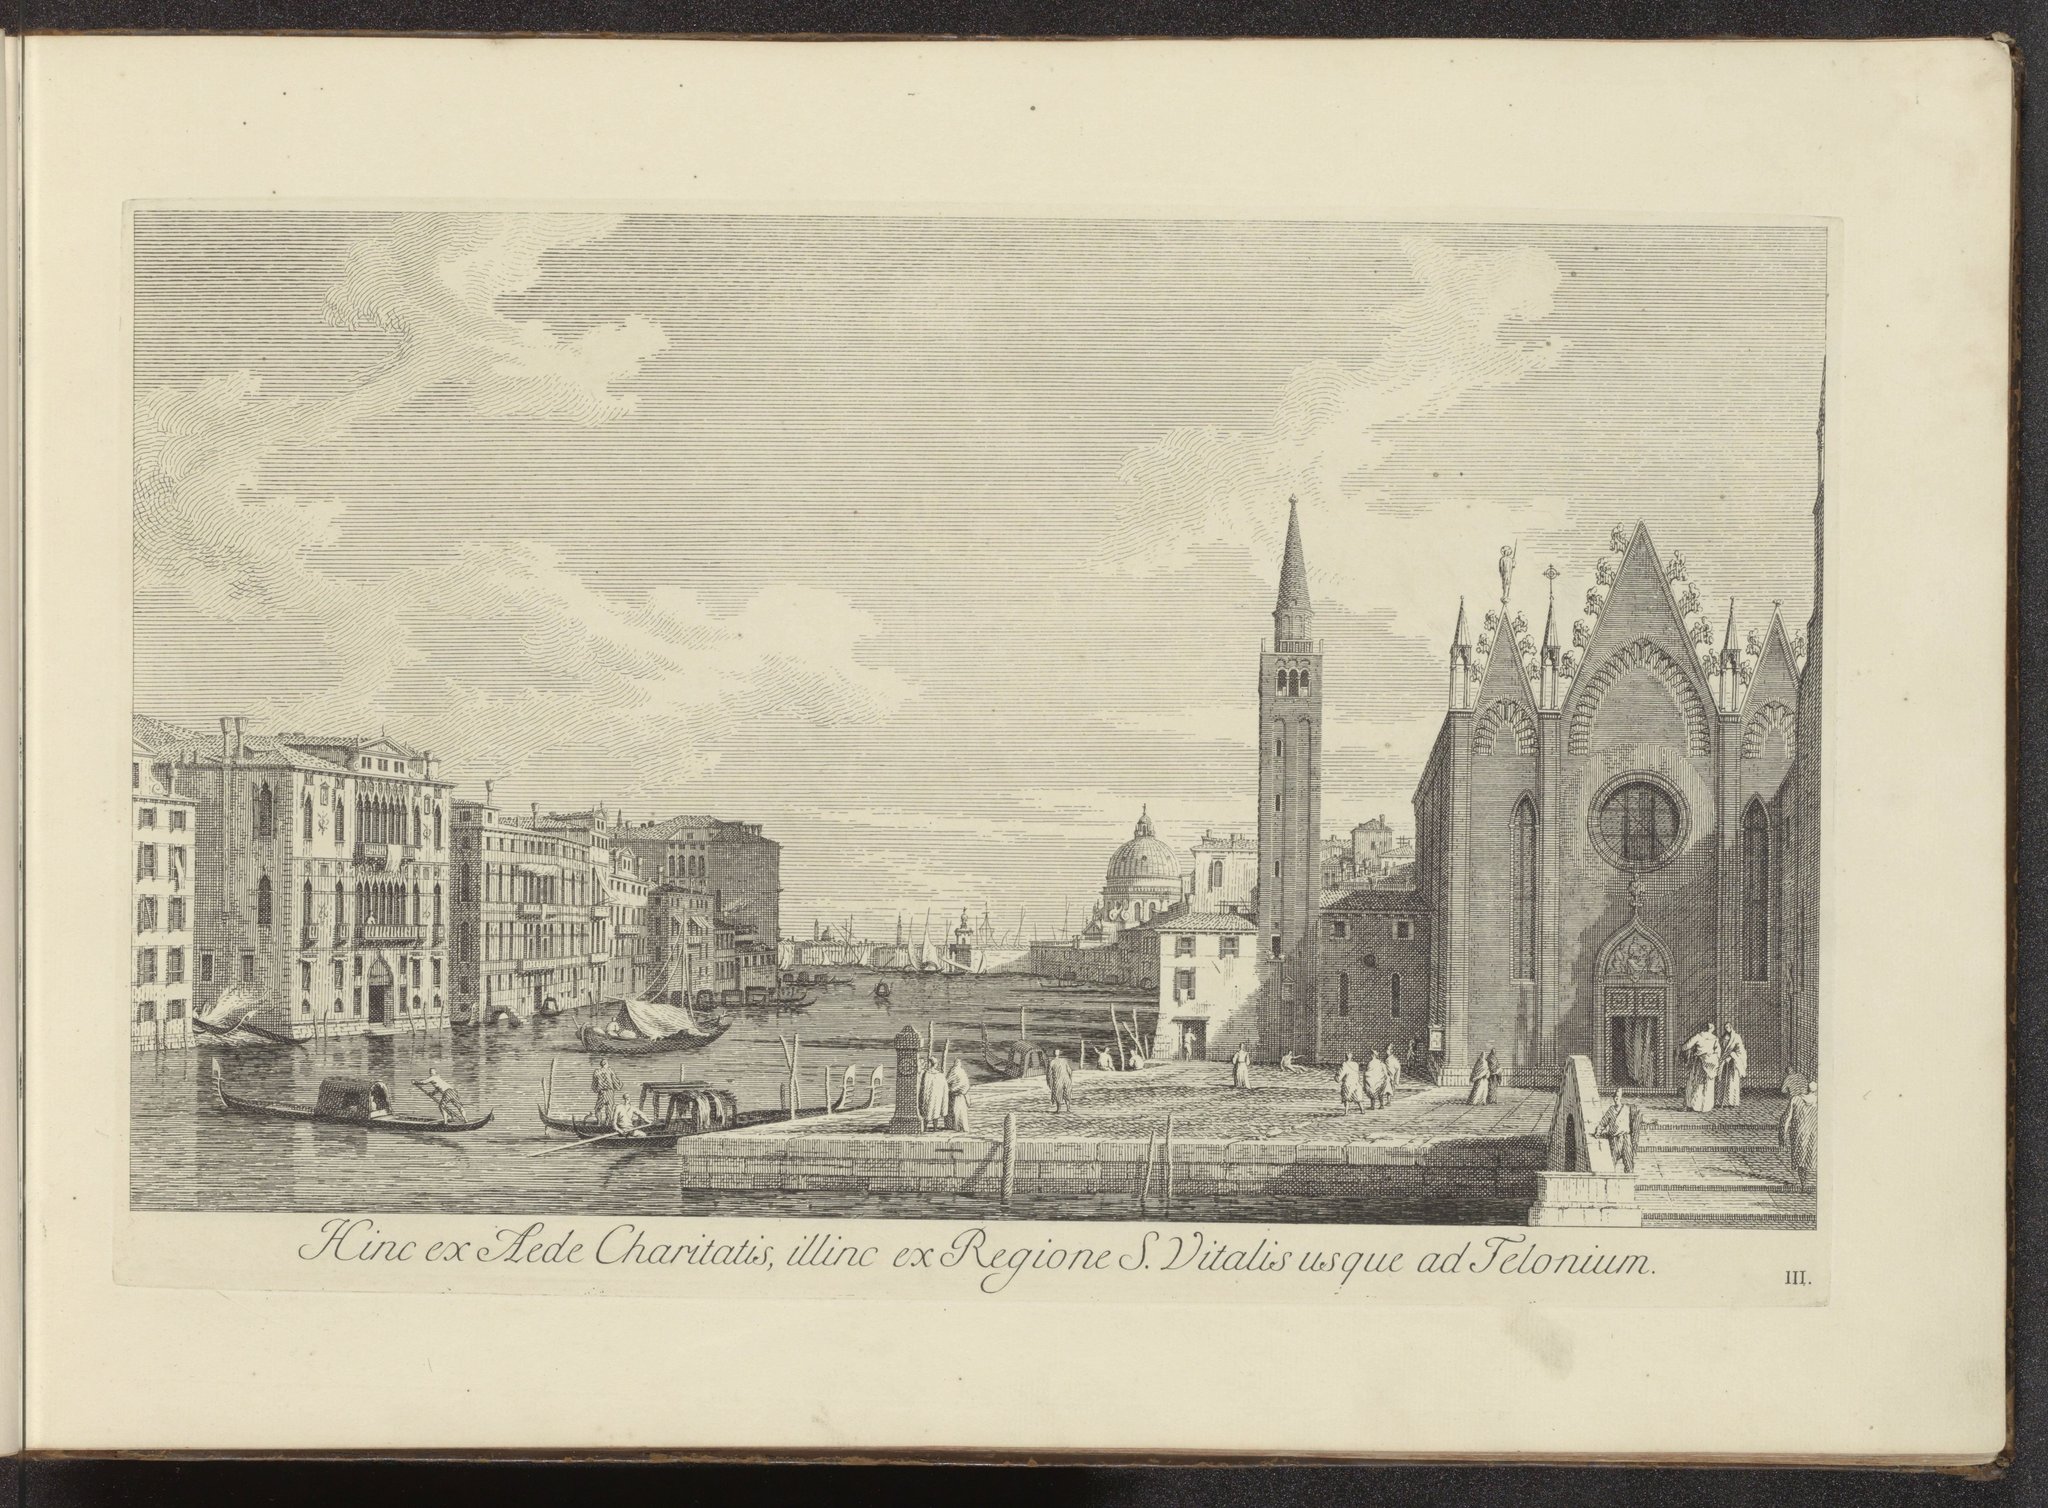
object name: album leaf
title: Gezicht op het Canal Grande en de Chiesa di Santa Maria della Carità te Venetië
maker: antonio visentini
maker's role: draughtsman, print maker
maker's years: 1688-1782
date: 1742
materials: paper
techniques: etching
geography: venice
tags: city-view, and landscape with man-made constructions, canal, church (exterior)